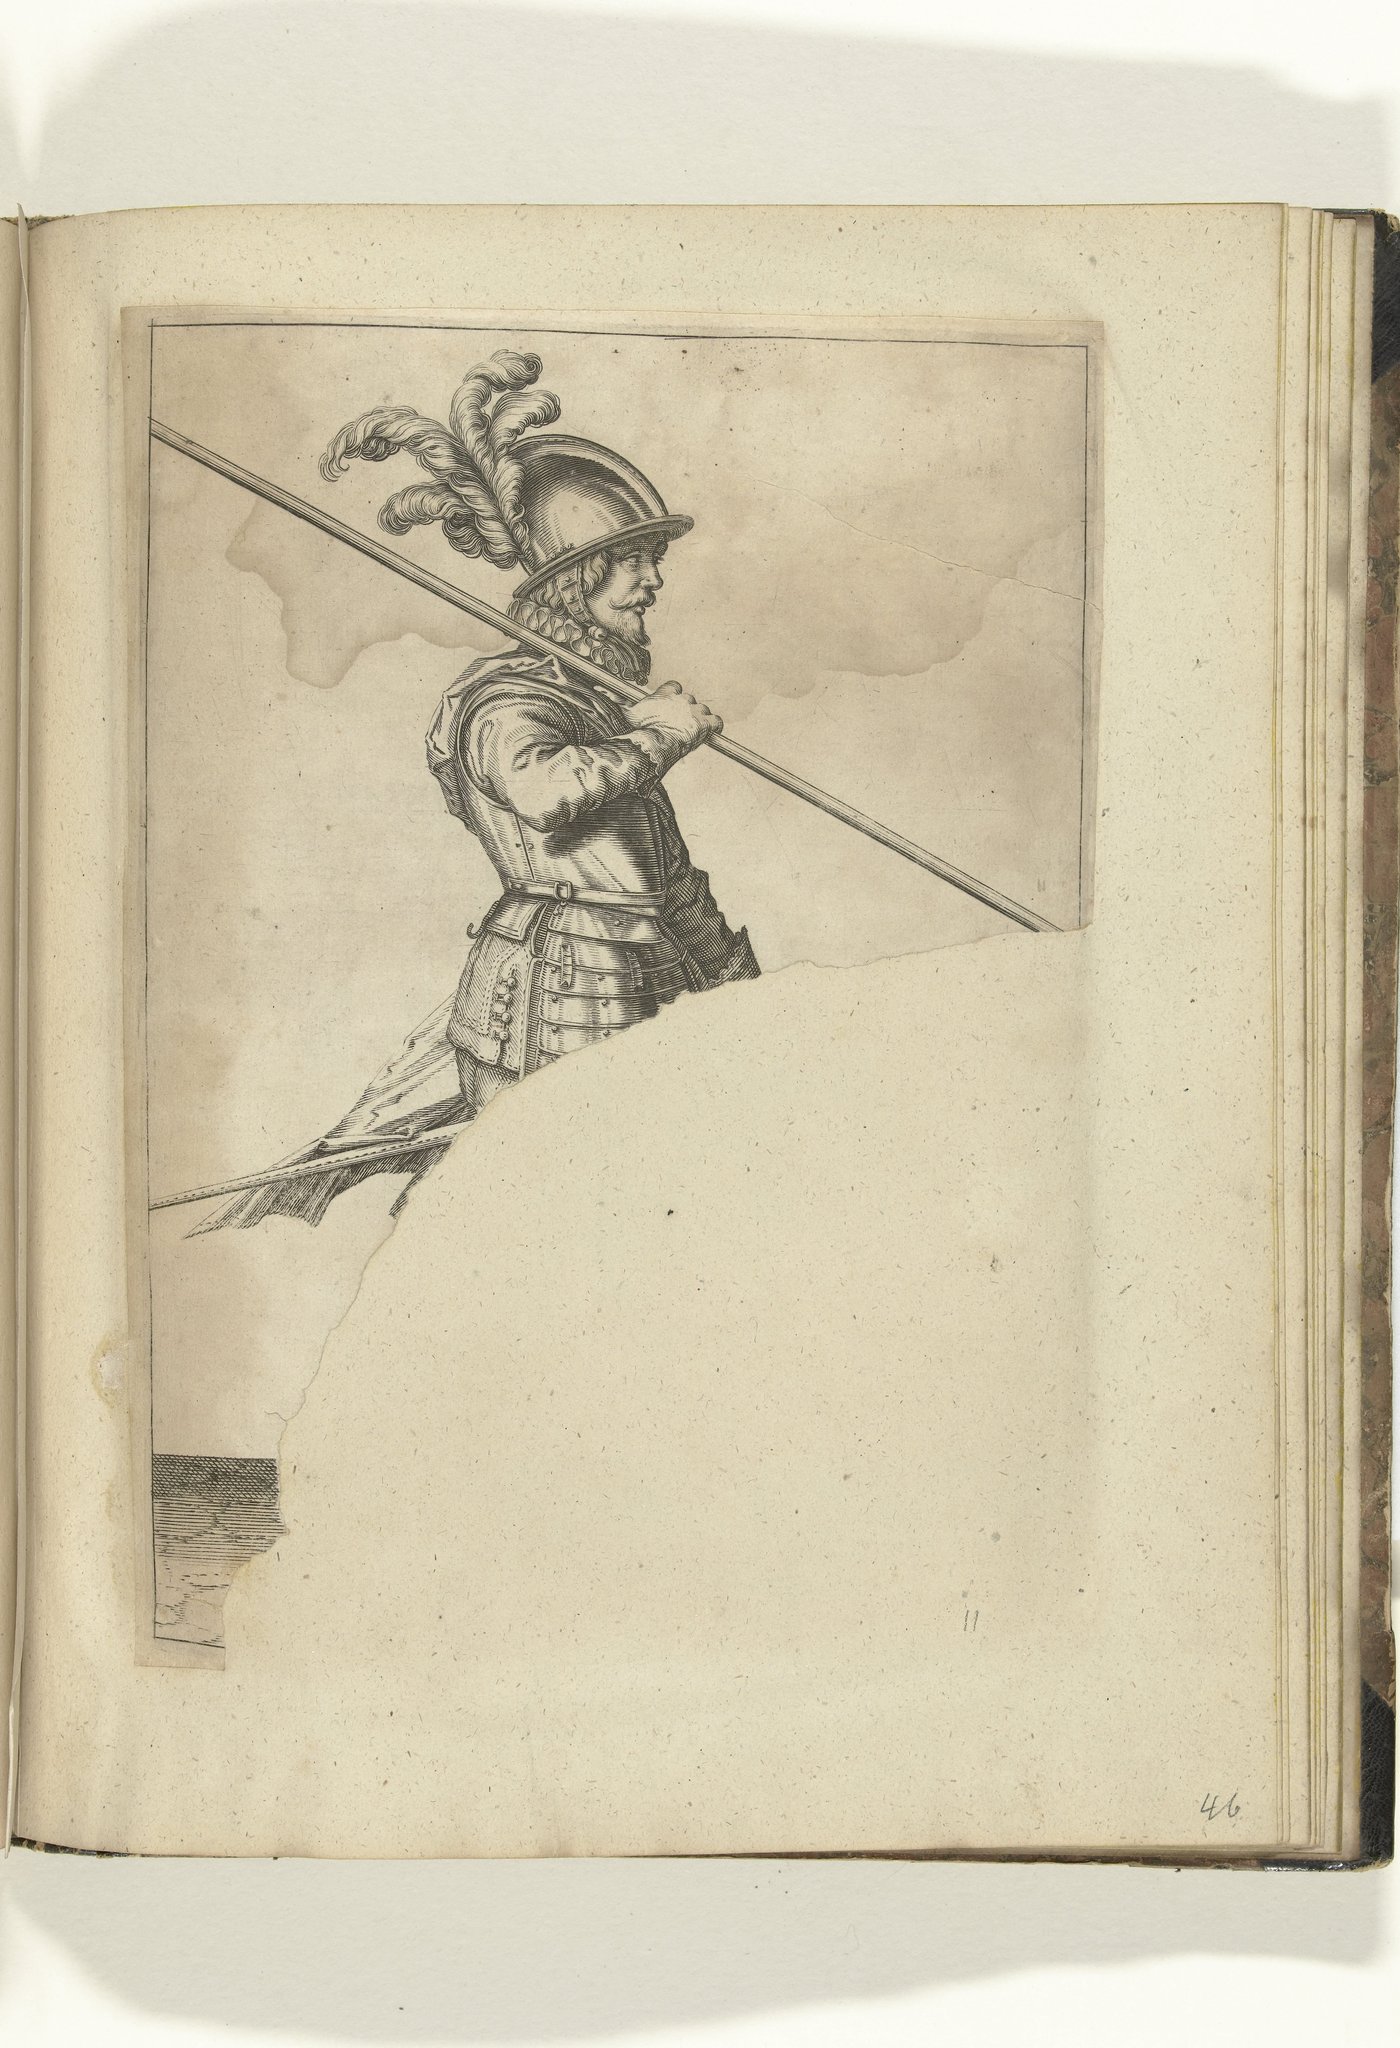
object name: print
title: Soldaat die zijn spies op zijn rechterschouder draagt, de punt schuin naar de grond gericht (nr. 11), ca. 1600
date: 1597-1608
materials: paper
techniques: engraving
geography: northern netherlands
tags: maurice (prince of orange), handling of weapons ~ military training, weapons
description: Een soldaat, ten voeten uit, naar rechts, die een spies (lans) op zijn rechterschouder draagt, de punt schuin naar de grond gericht (nr. 11), ca. 1600. Zijn rechterhand om de spies. Plaat 11 in de instructies voor het hanteren van de spies: Brief instruction upon the contrefaictinges, concerning the right use, of all what a Souldier needeth to know in handling of the Pike. Onderdeel van de illustraties in een Engelse editie van J. de Gheyns Wapenhandelinghe: J. de Gheyn, The exercise of armes for calivres, muskettes and pikes after the ordre of Maurits Prince of Orange, 's-Gravenhage 1608. Krijgswezen rond 1600.